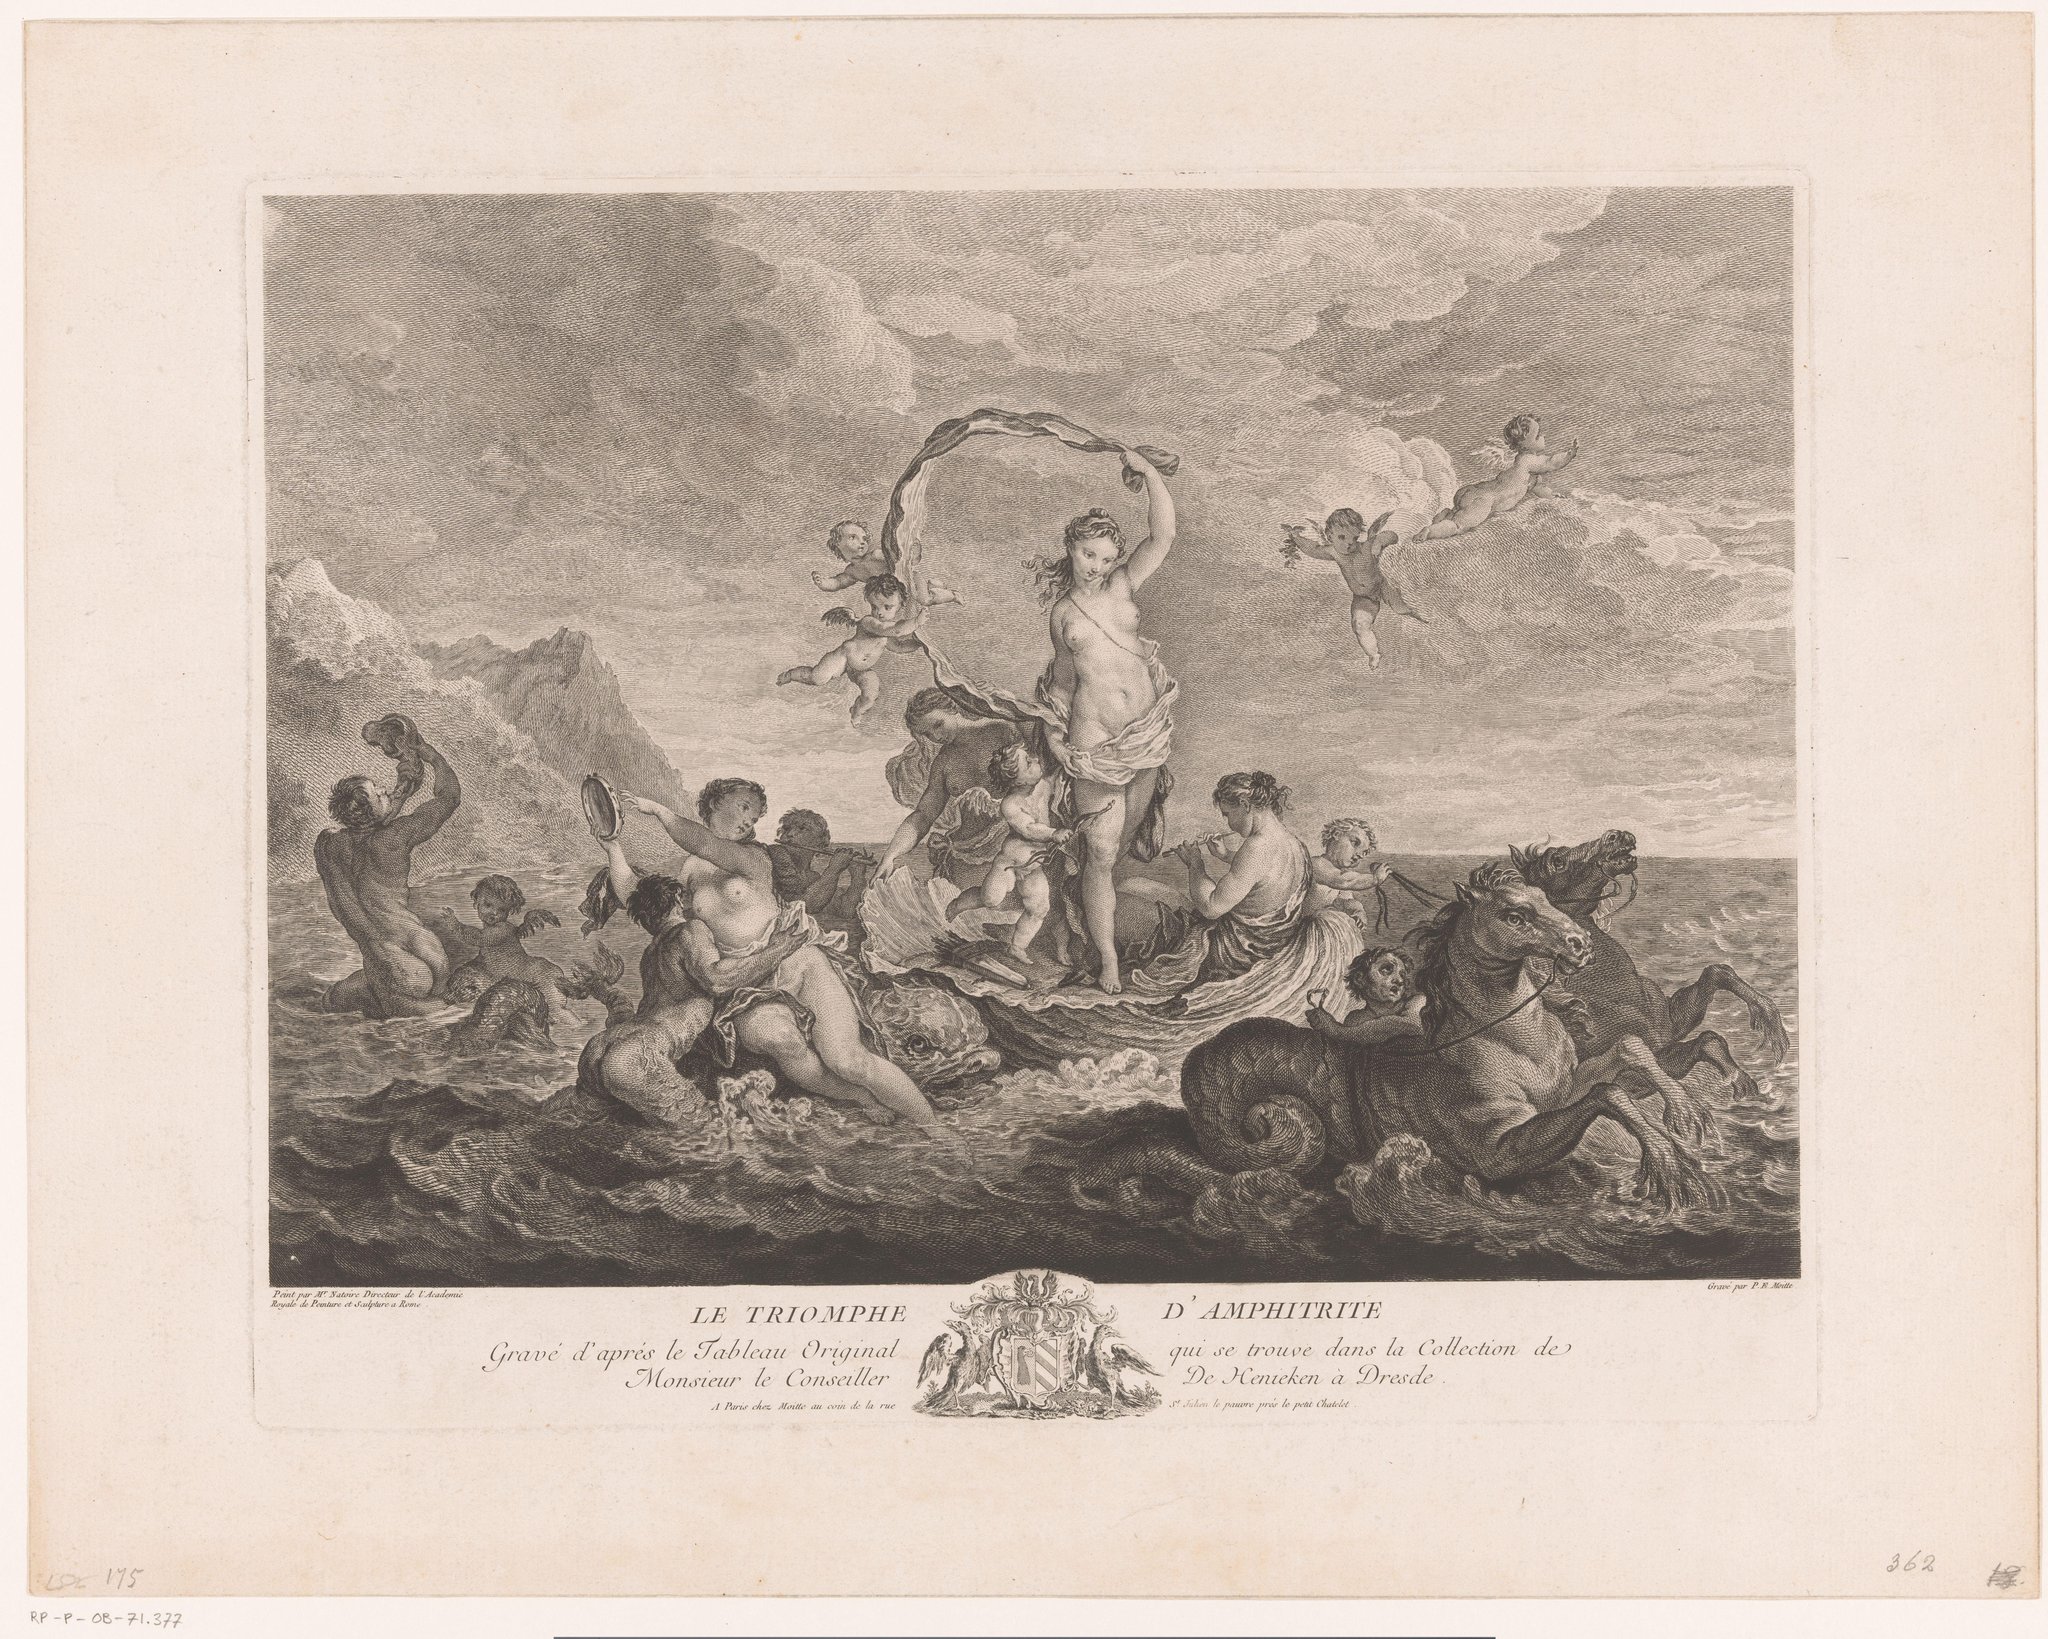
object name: print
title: Le Triomphe d'Amphitrite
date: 1751-1780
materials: paper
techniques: engraving, etching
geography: paris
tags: triumph of amphitrite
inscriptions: collector's mark: Lugt 240